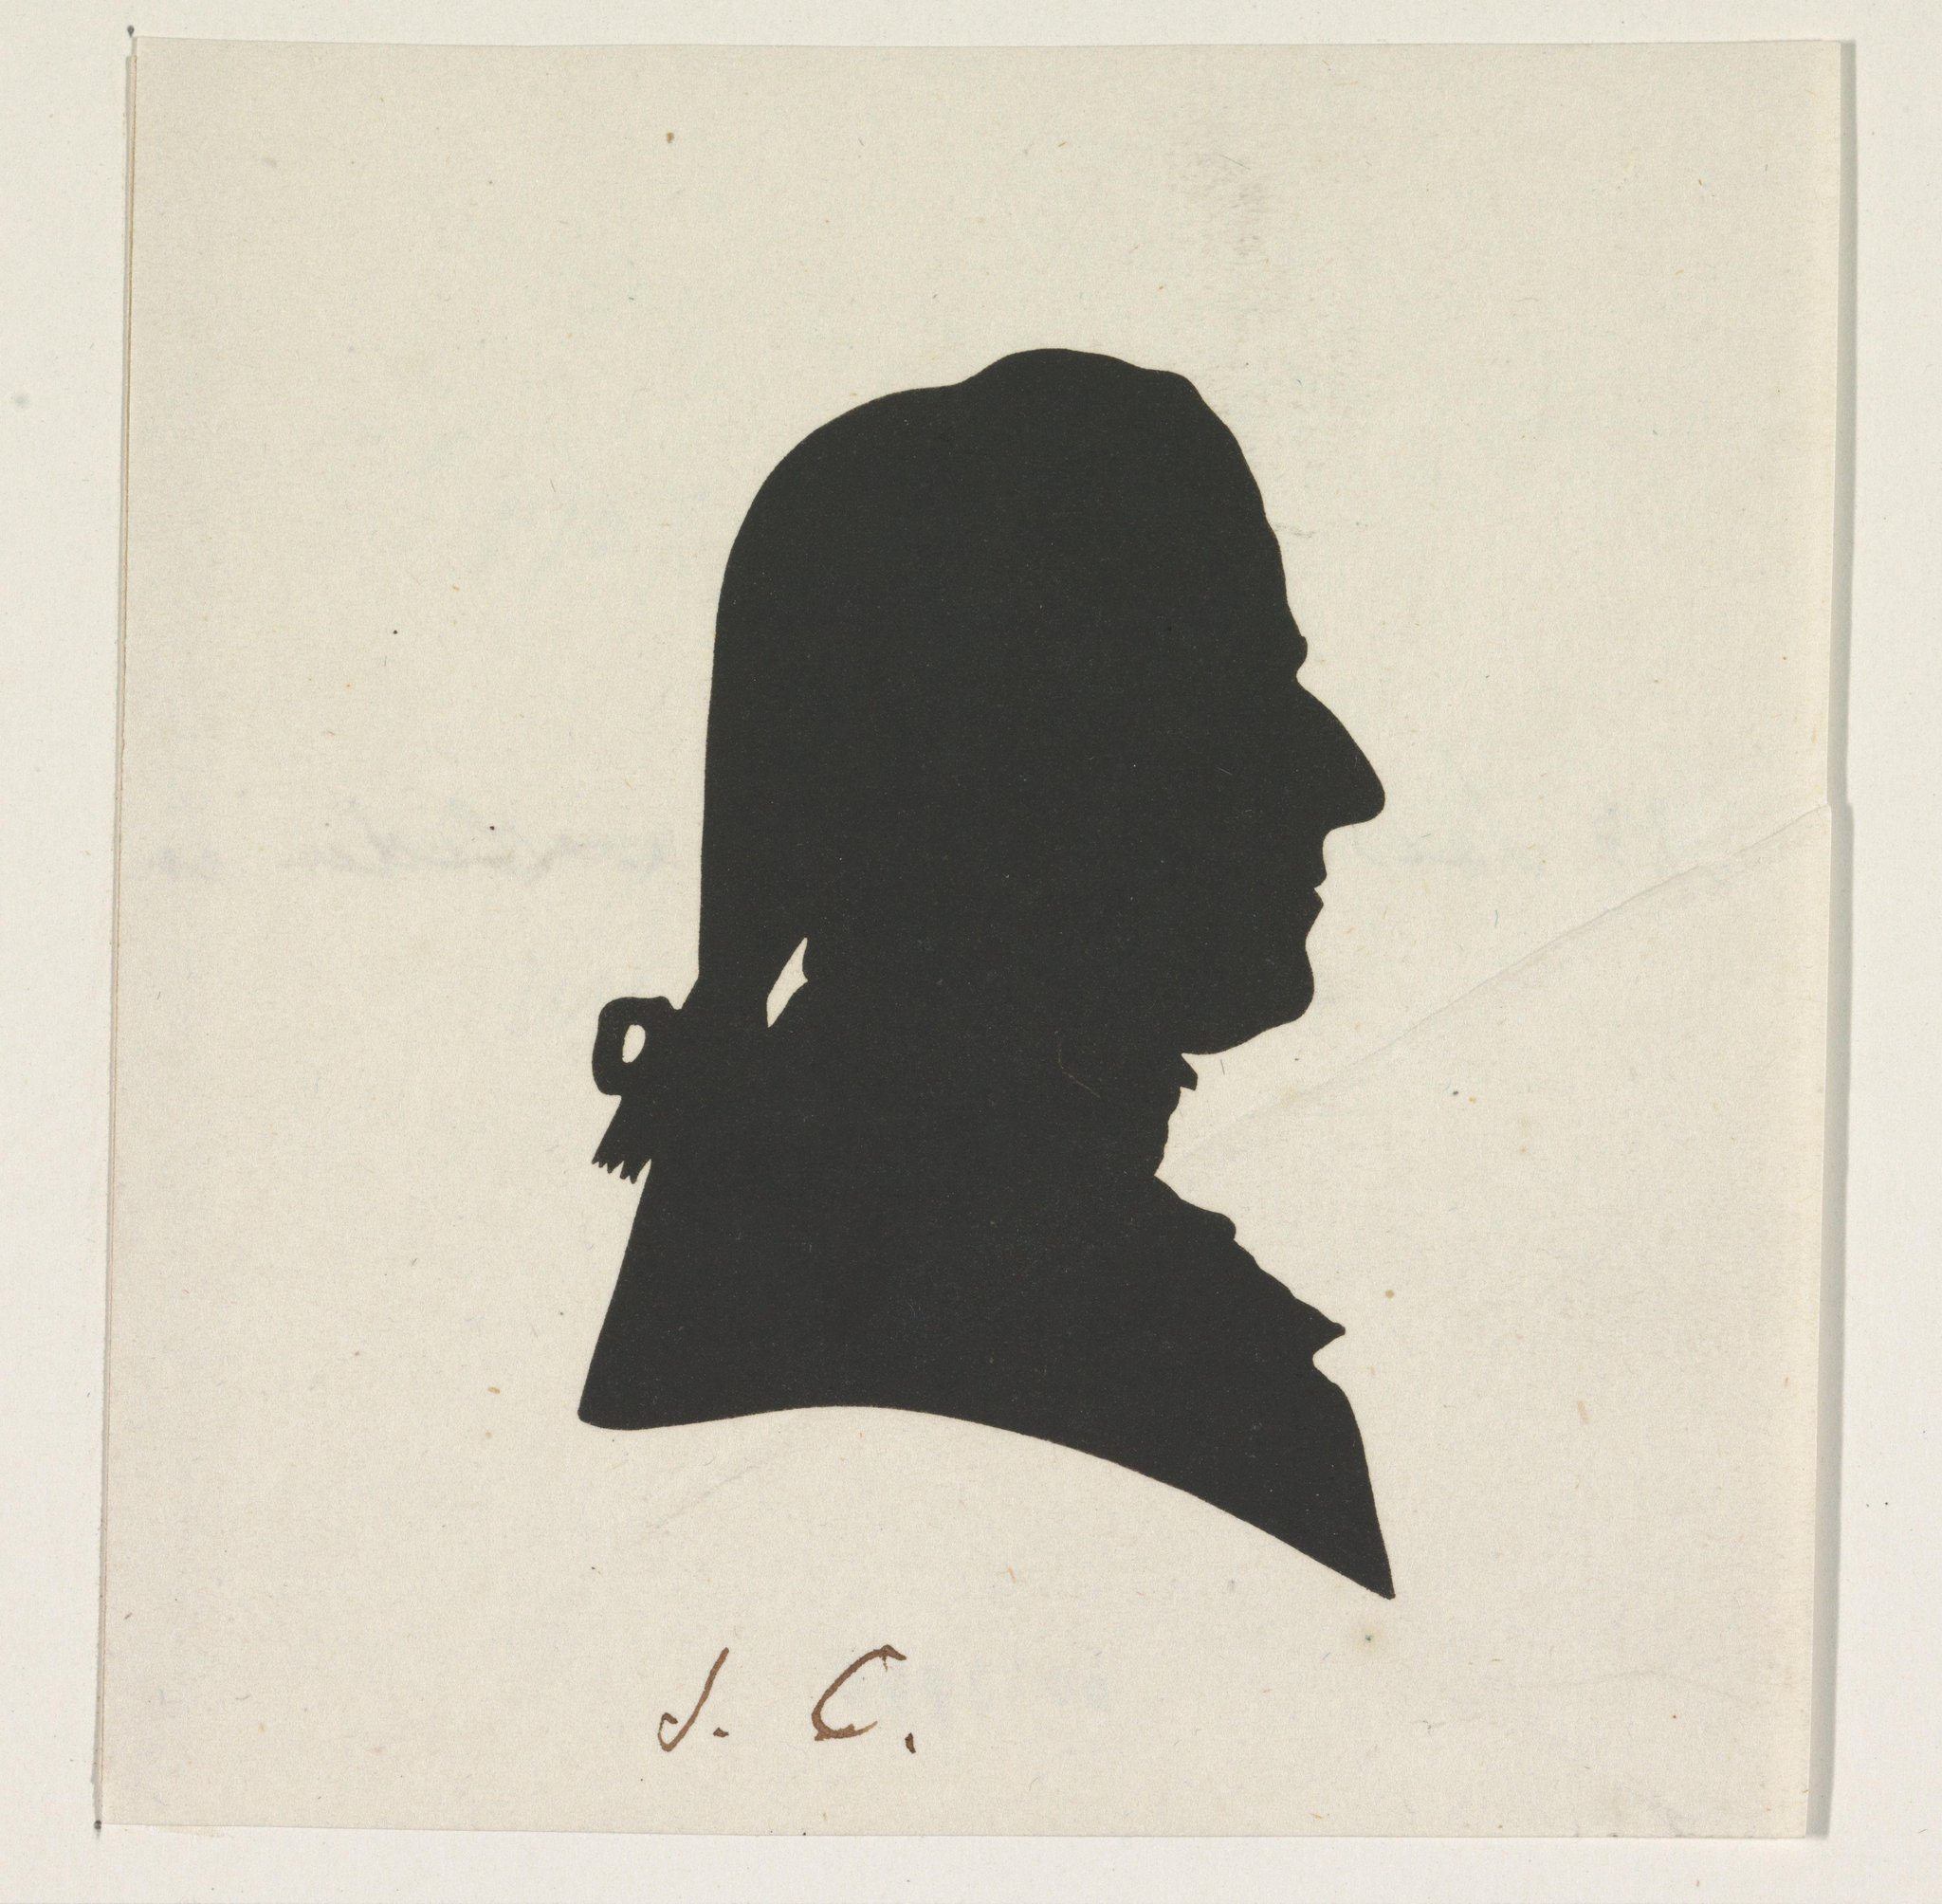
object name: drawing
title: Silhouet van Jacob Camper, naar rechts kijkend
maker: Anonymous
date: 1700-1900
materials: paper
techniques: brush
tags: historical persons, male sex; man